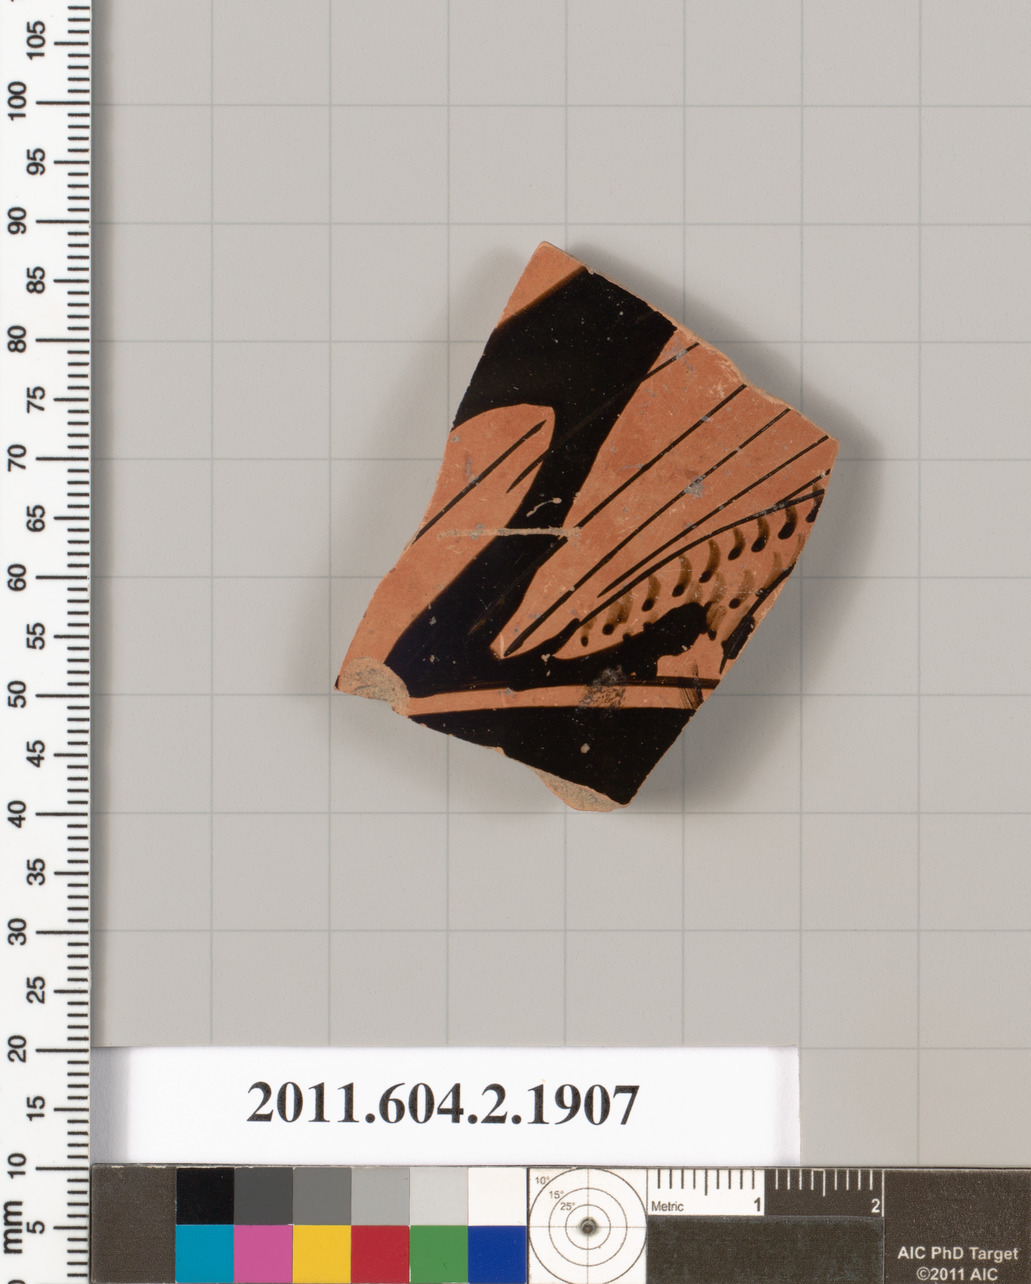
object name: skyphos fragment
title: Terracotta fragment of a skyphos (deep drinking cup)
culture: greek, attic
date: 460-430 BCE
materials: terracotta